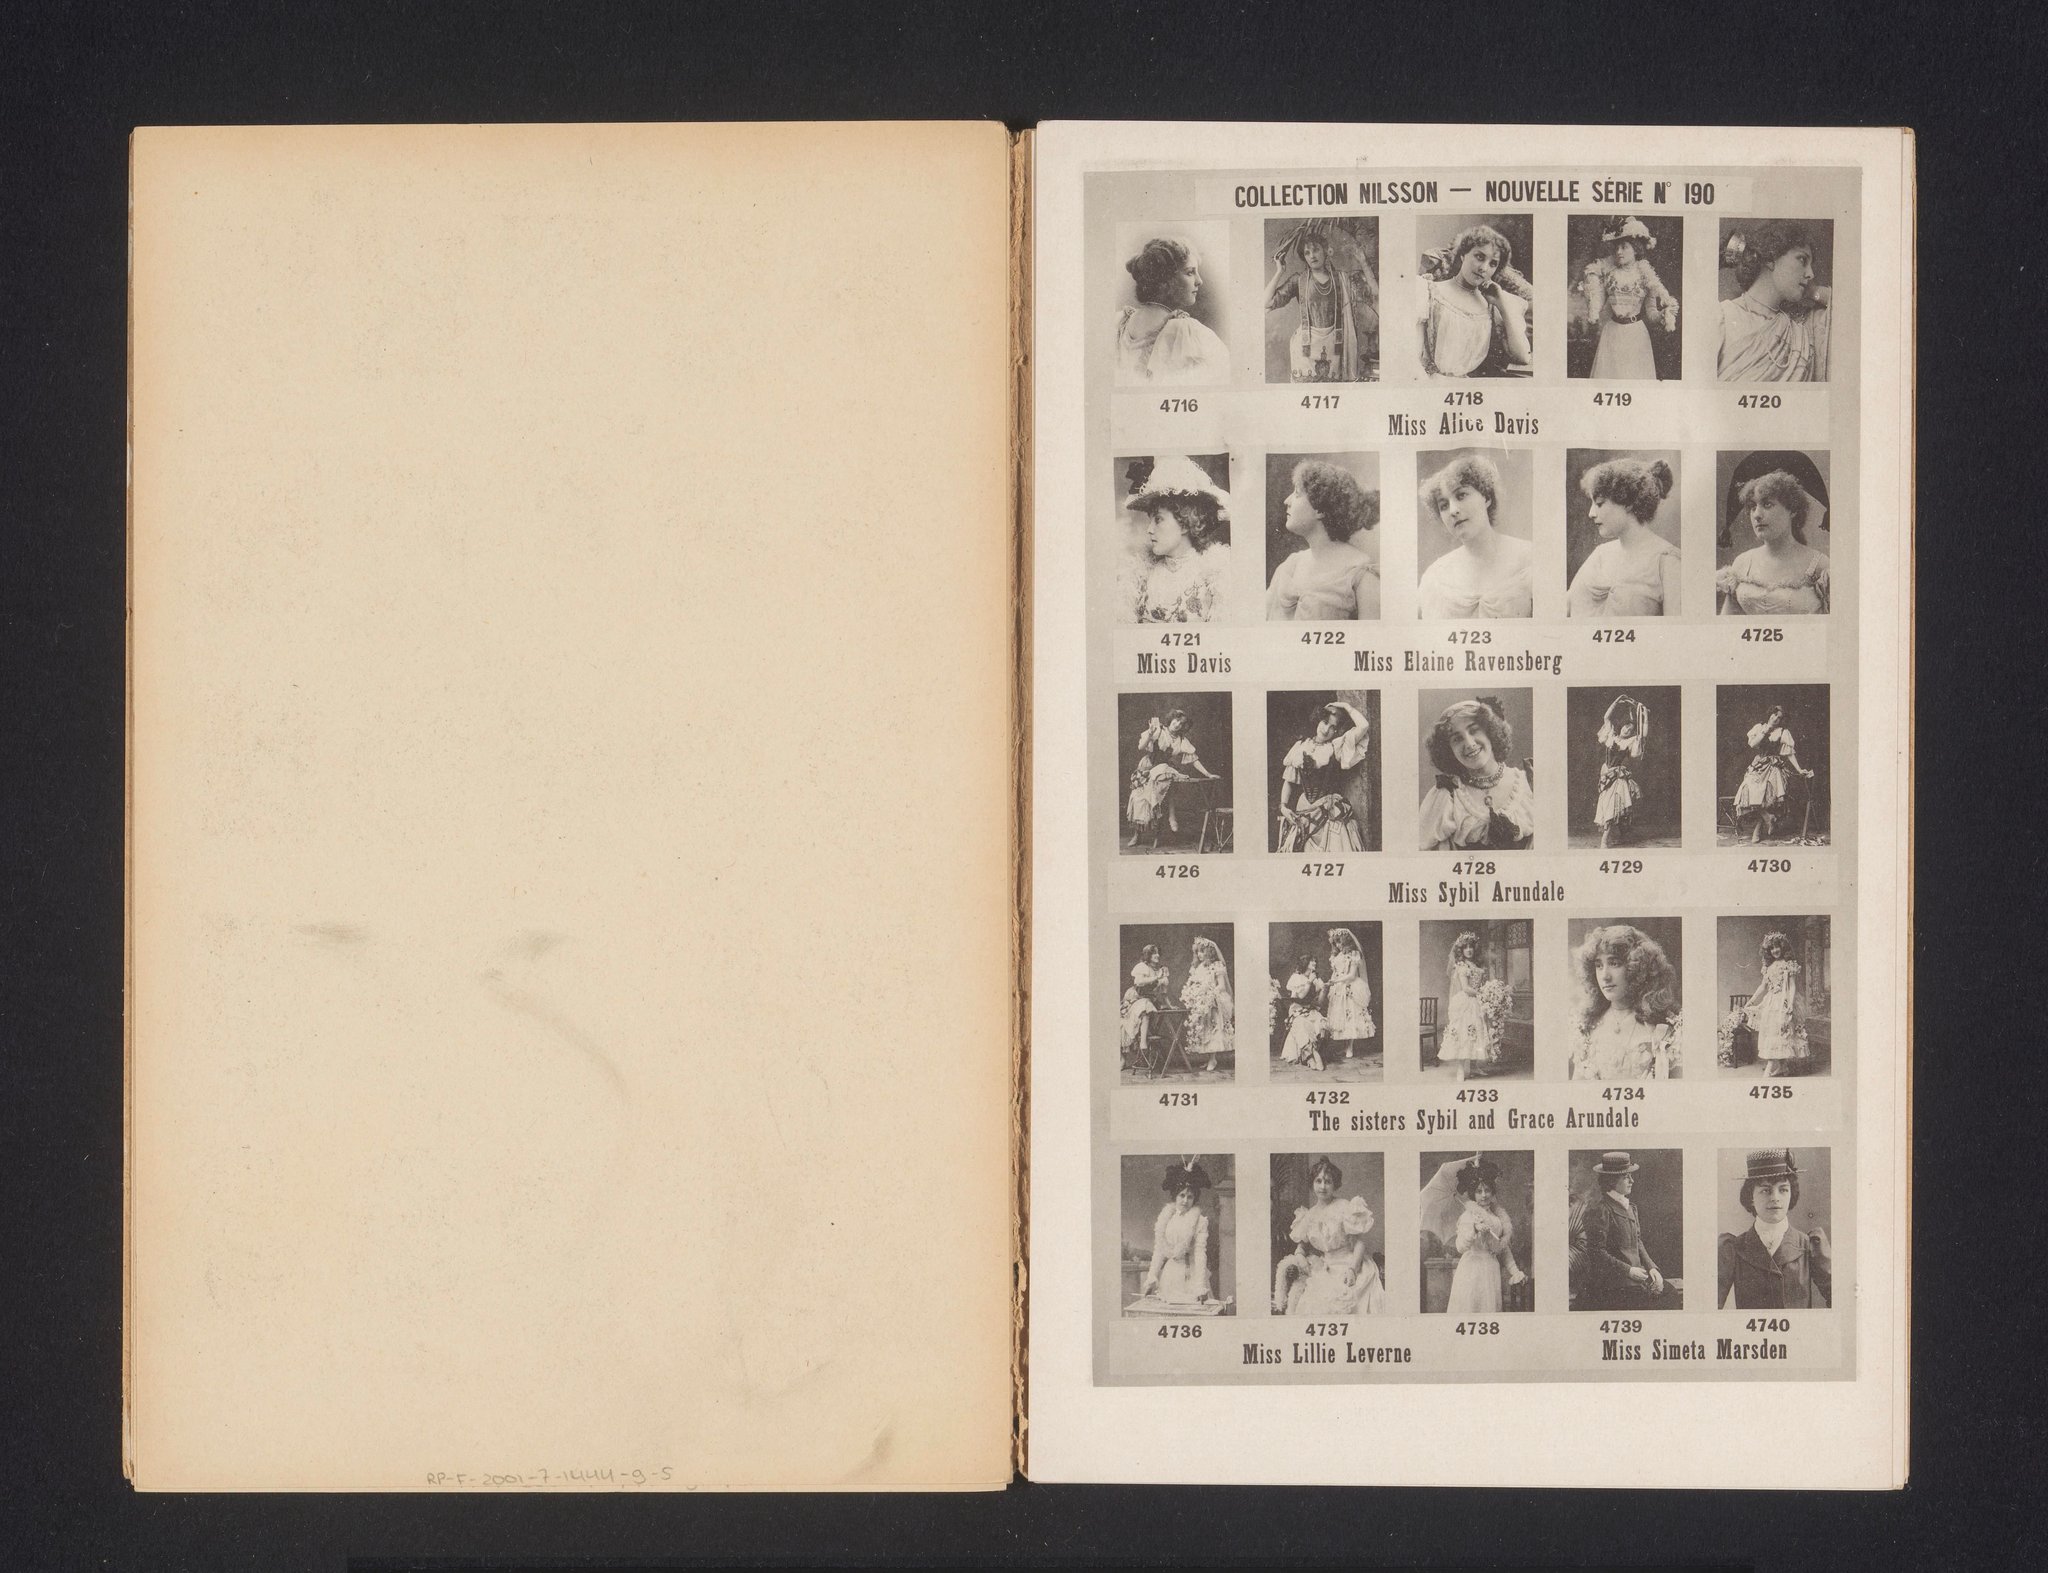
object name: page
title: Collection Nilsson - Nouvelle Série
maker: Anonymous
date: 1894-1899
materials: paper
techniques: photograph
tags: london, historical persons - bb - woman, portrait of actor, actress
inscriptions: number: ‘No 190’